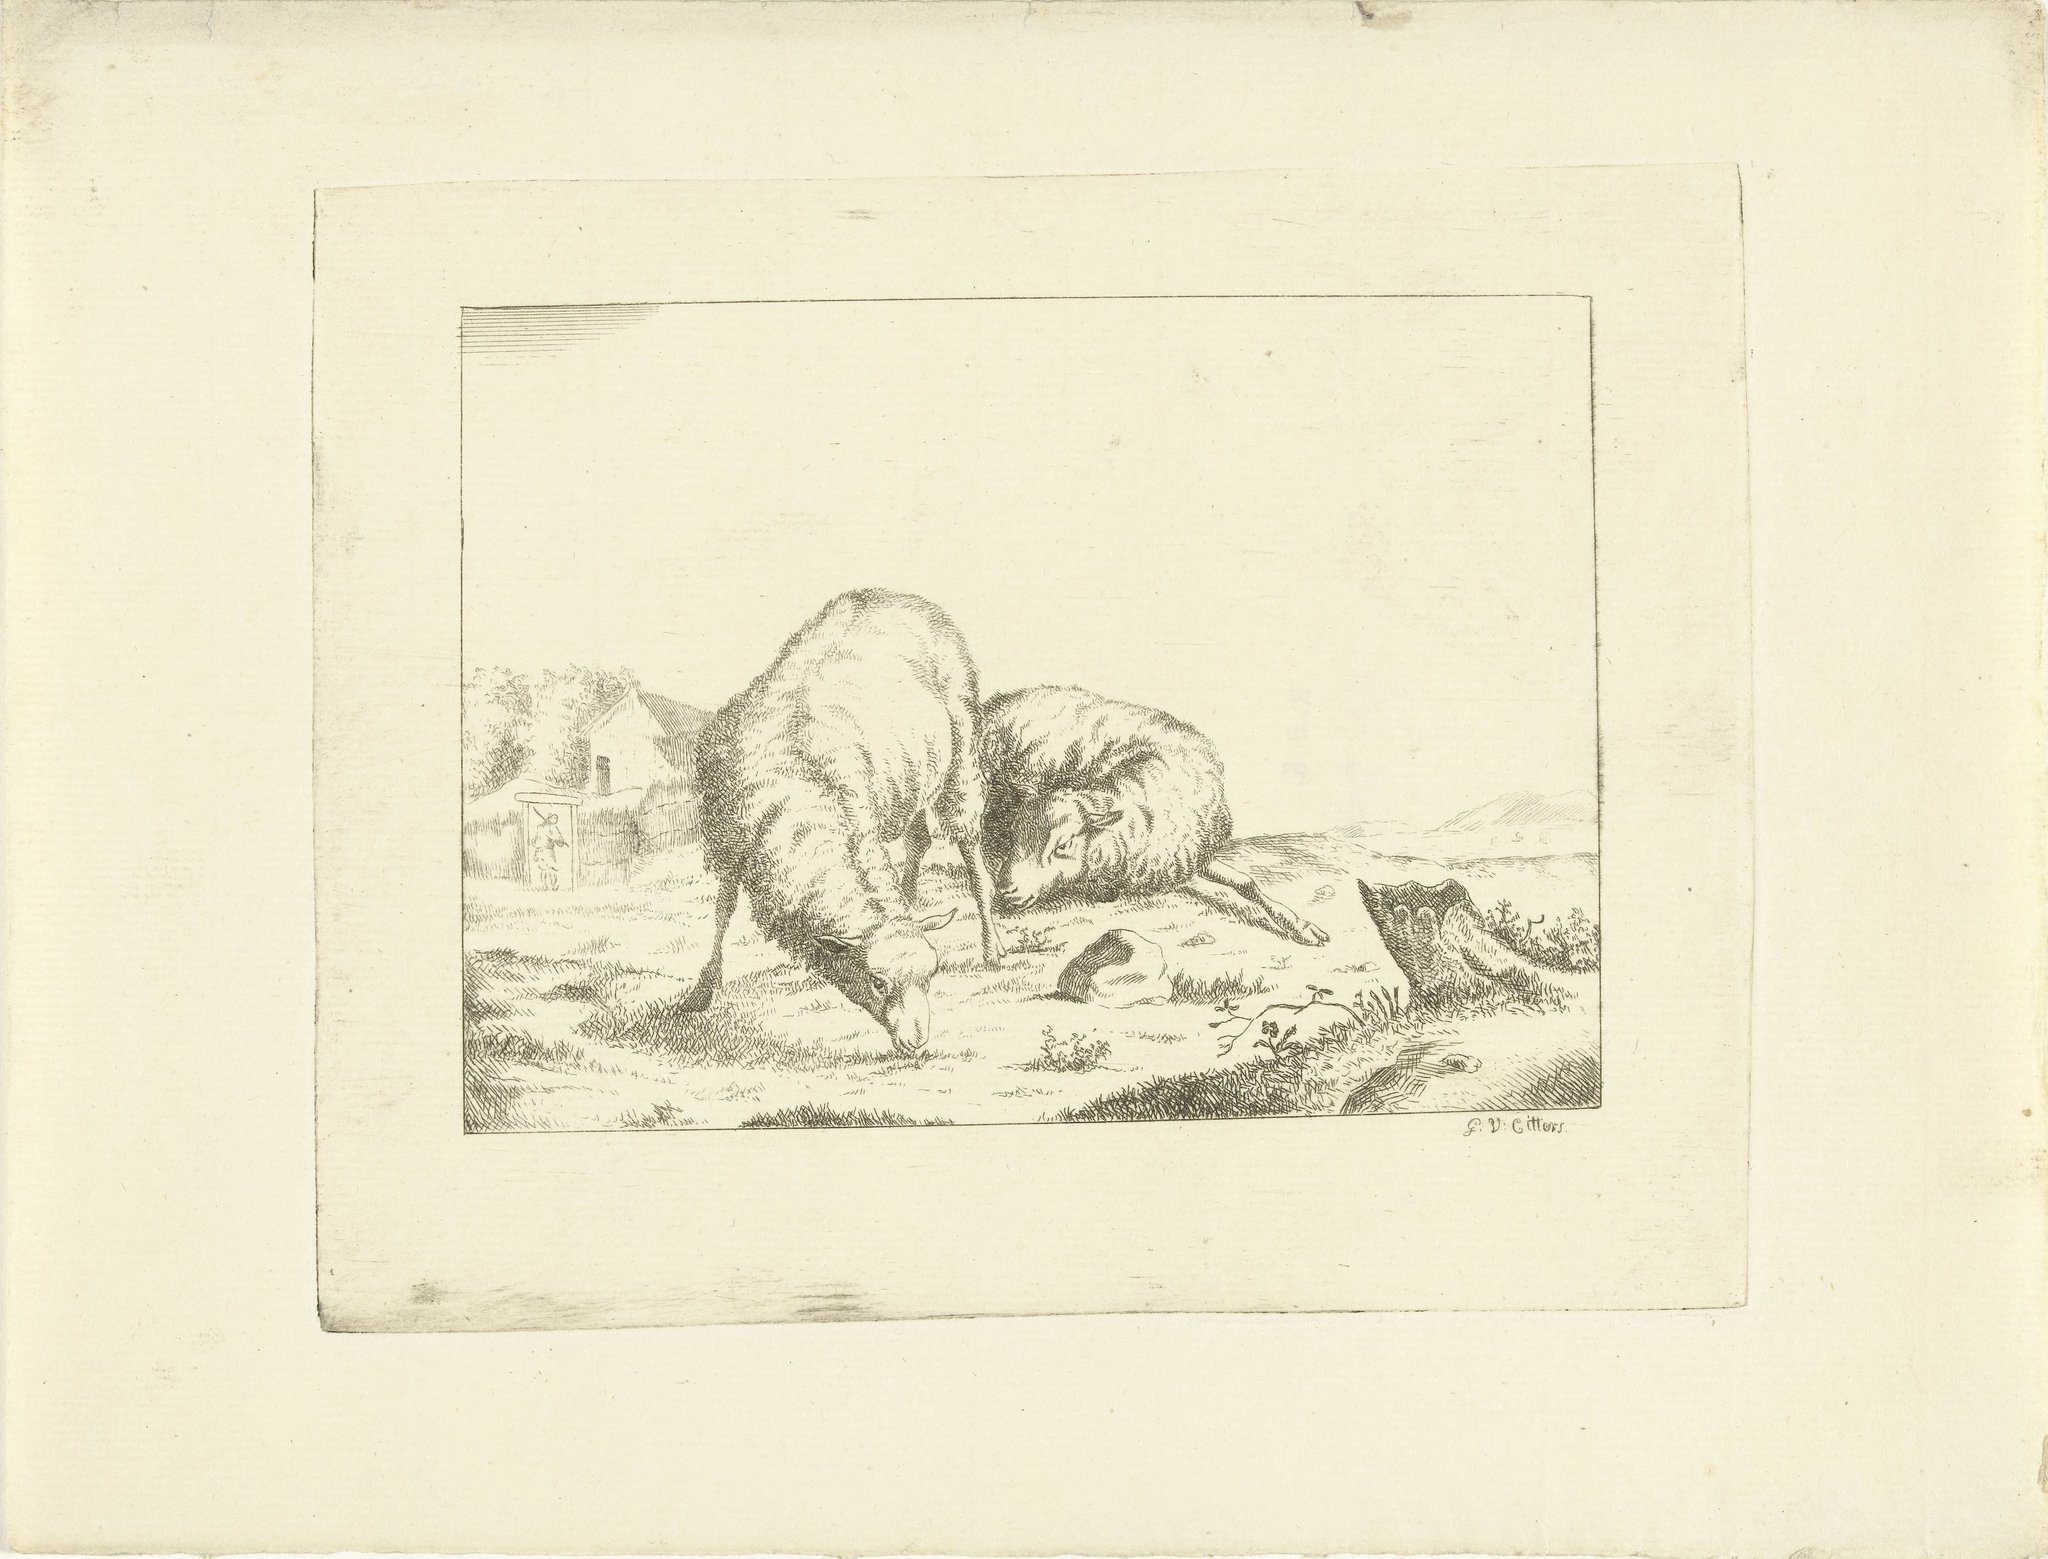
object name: print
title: Twee schapen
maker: g. van citters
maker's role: print maker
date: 1750-1800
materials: paper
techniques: etching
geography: netherlands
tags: sheep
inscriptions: collector's mark: Lugt 2233